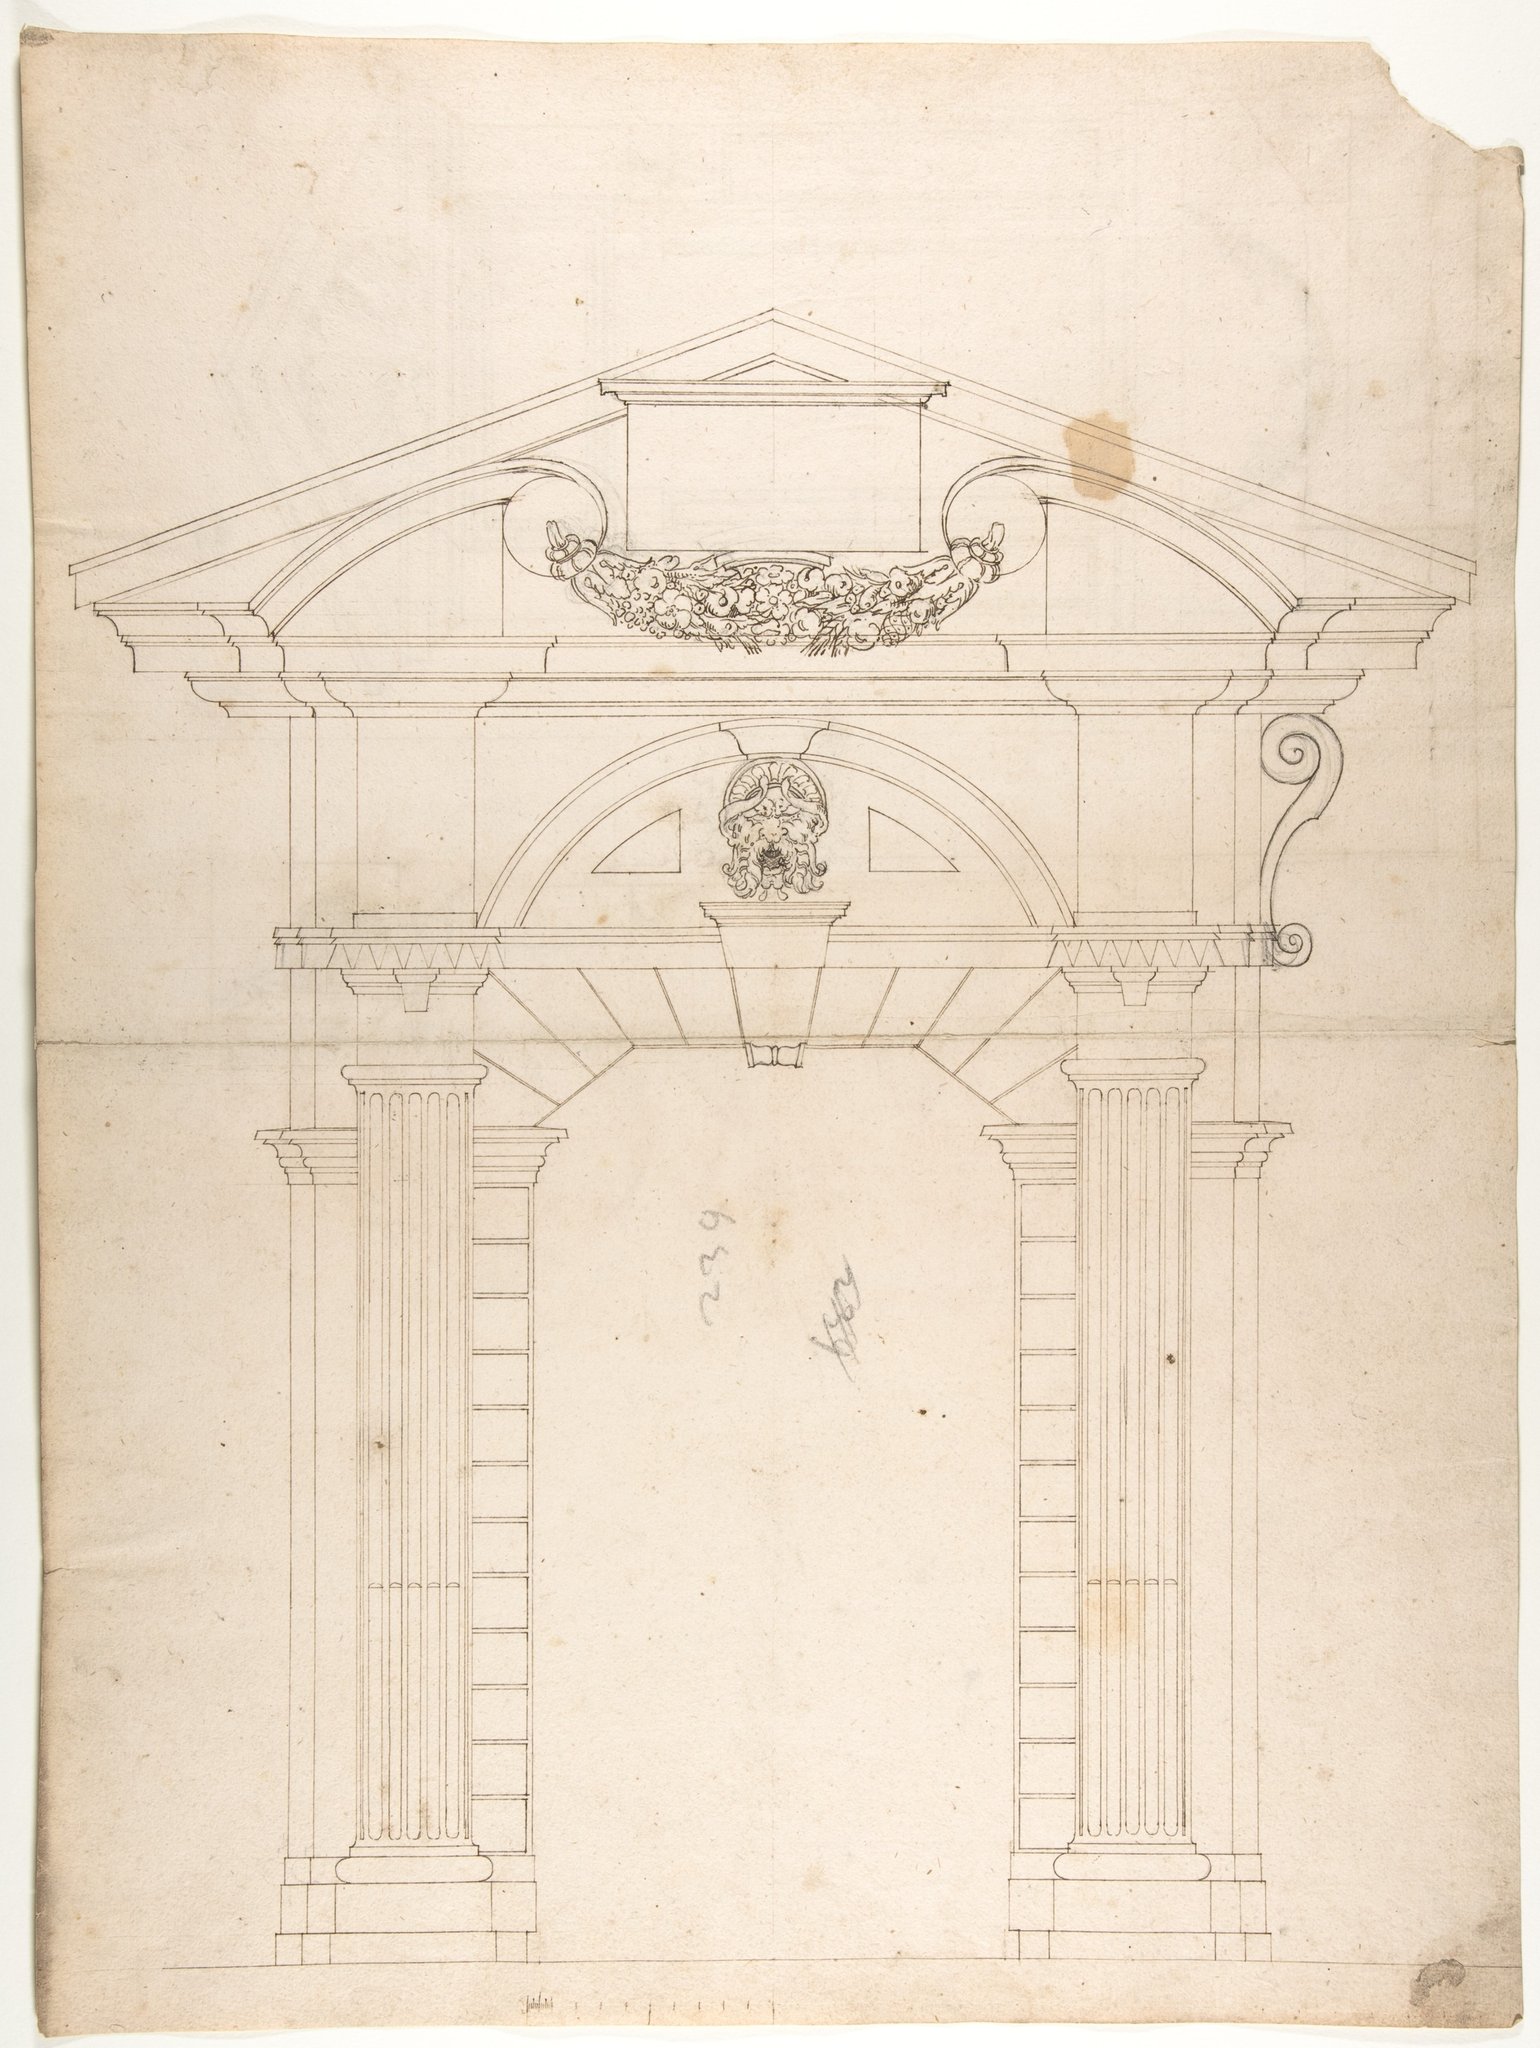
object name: drawing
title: Porta Pia, elevation (recto) Porta Pia, window, elevation; section (verso)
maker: anonymous, french, 16th century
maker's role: draftsman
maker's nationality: french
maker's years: 1500-1600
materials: chalk, ink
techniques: incising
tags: architecture